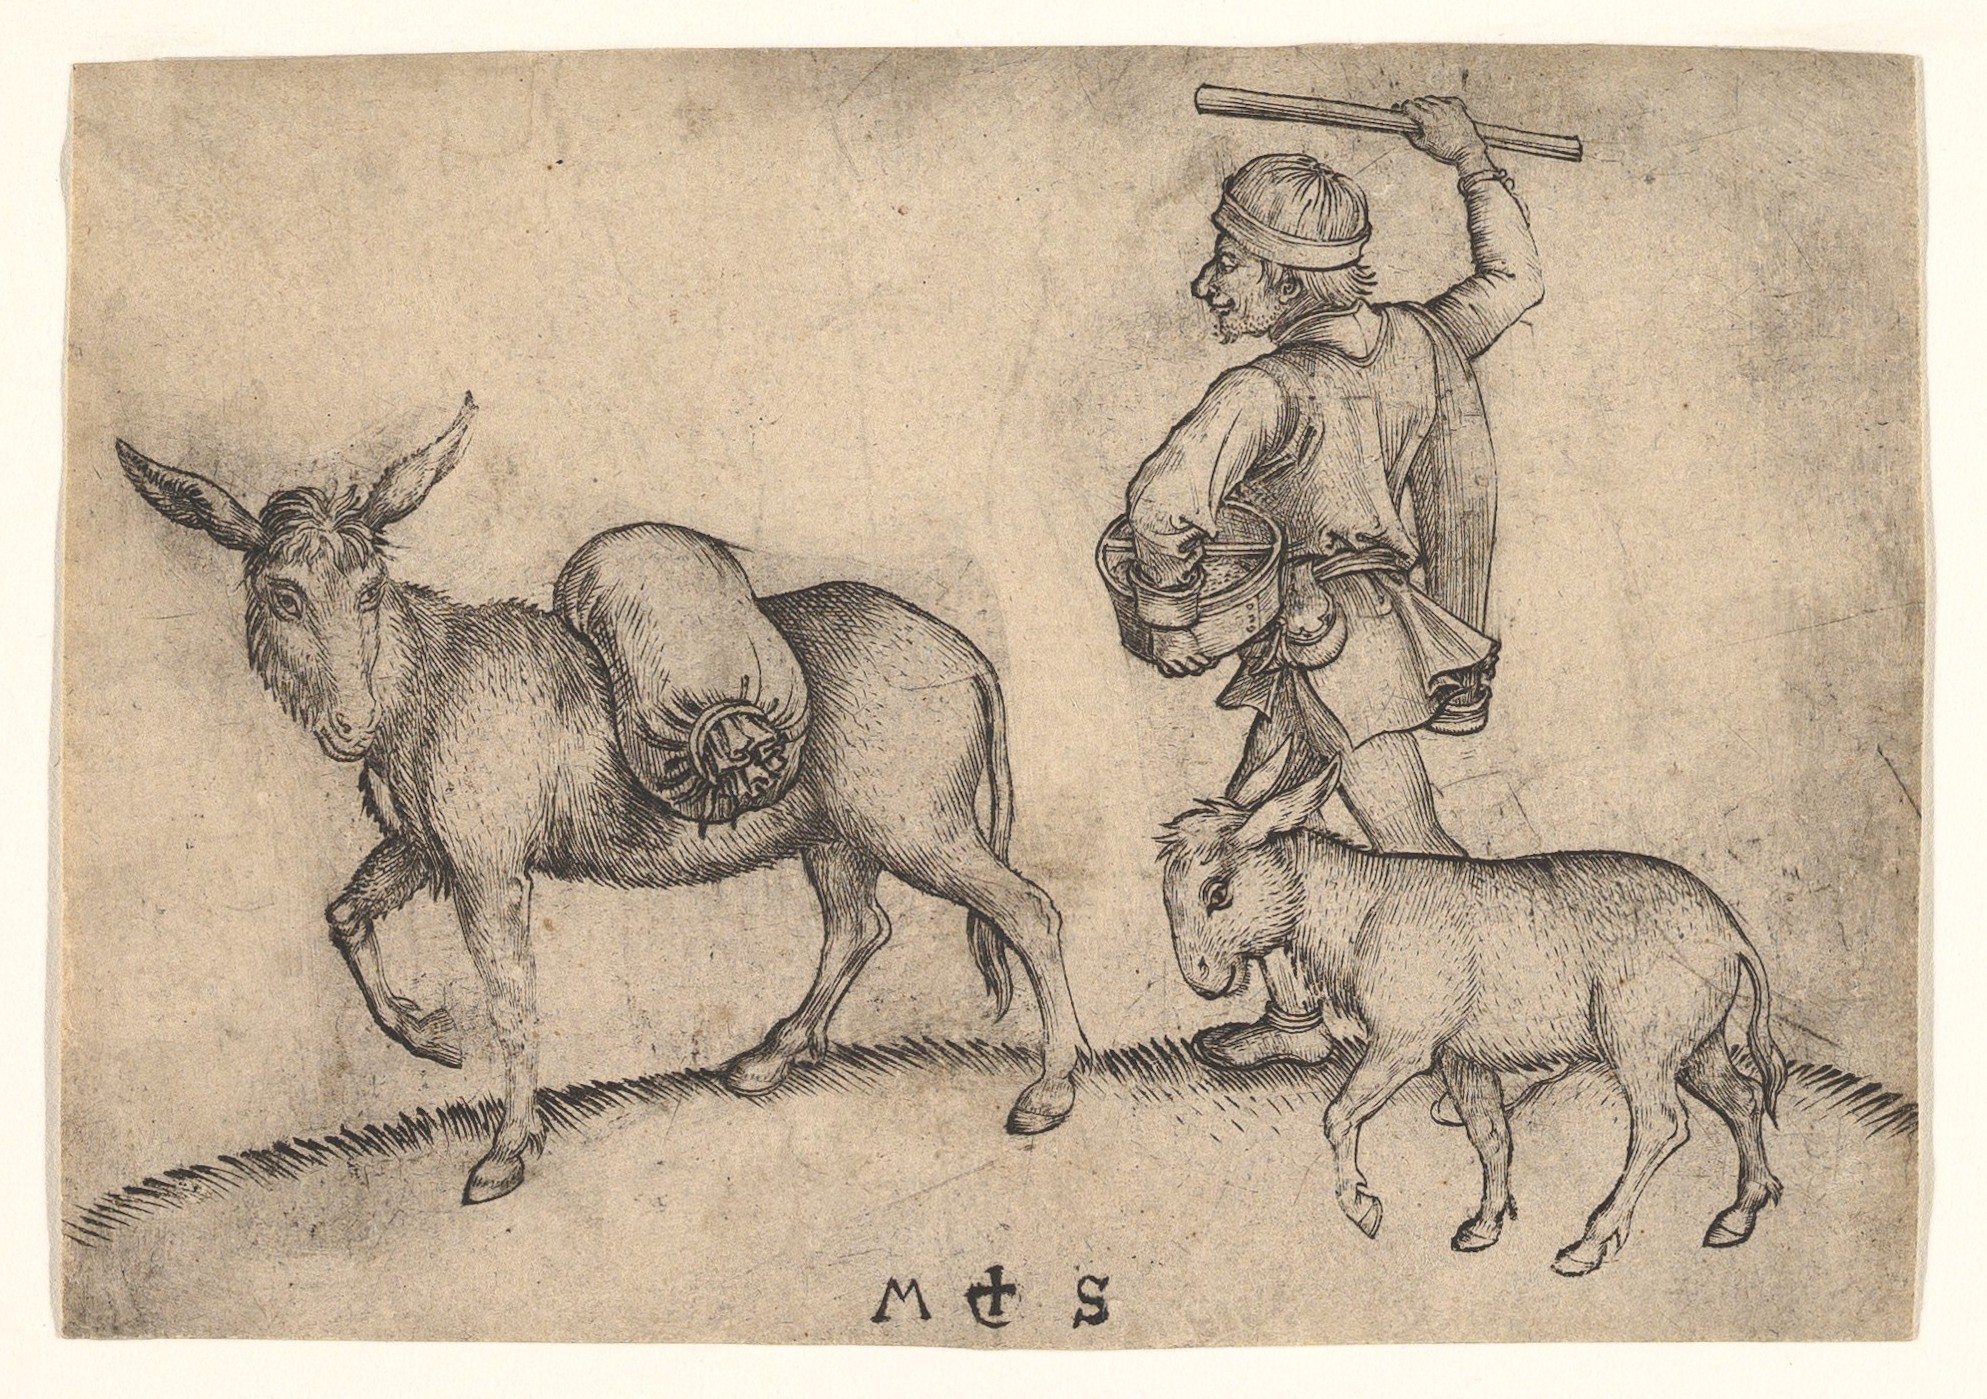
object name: print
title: The Miller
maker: martin schongauer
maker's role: artist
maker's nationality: german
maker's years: 1430-1491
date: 1470-1491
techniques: engraving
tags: men,donkeys